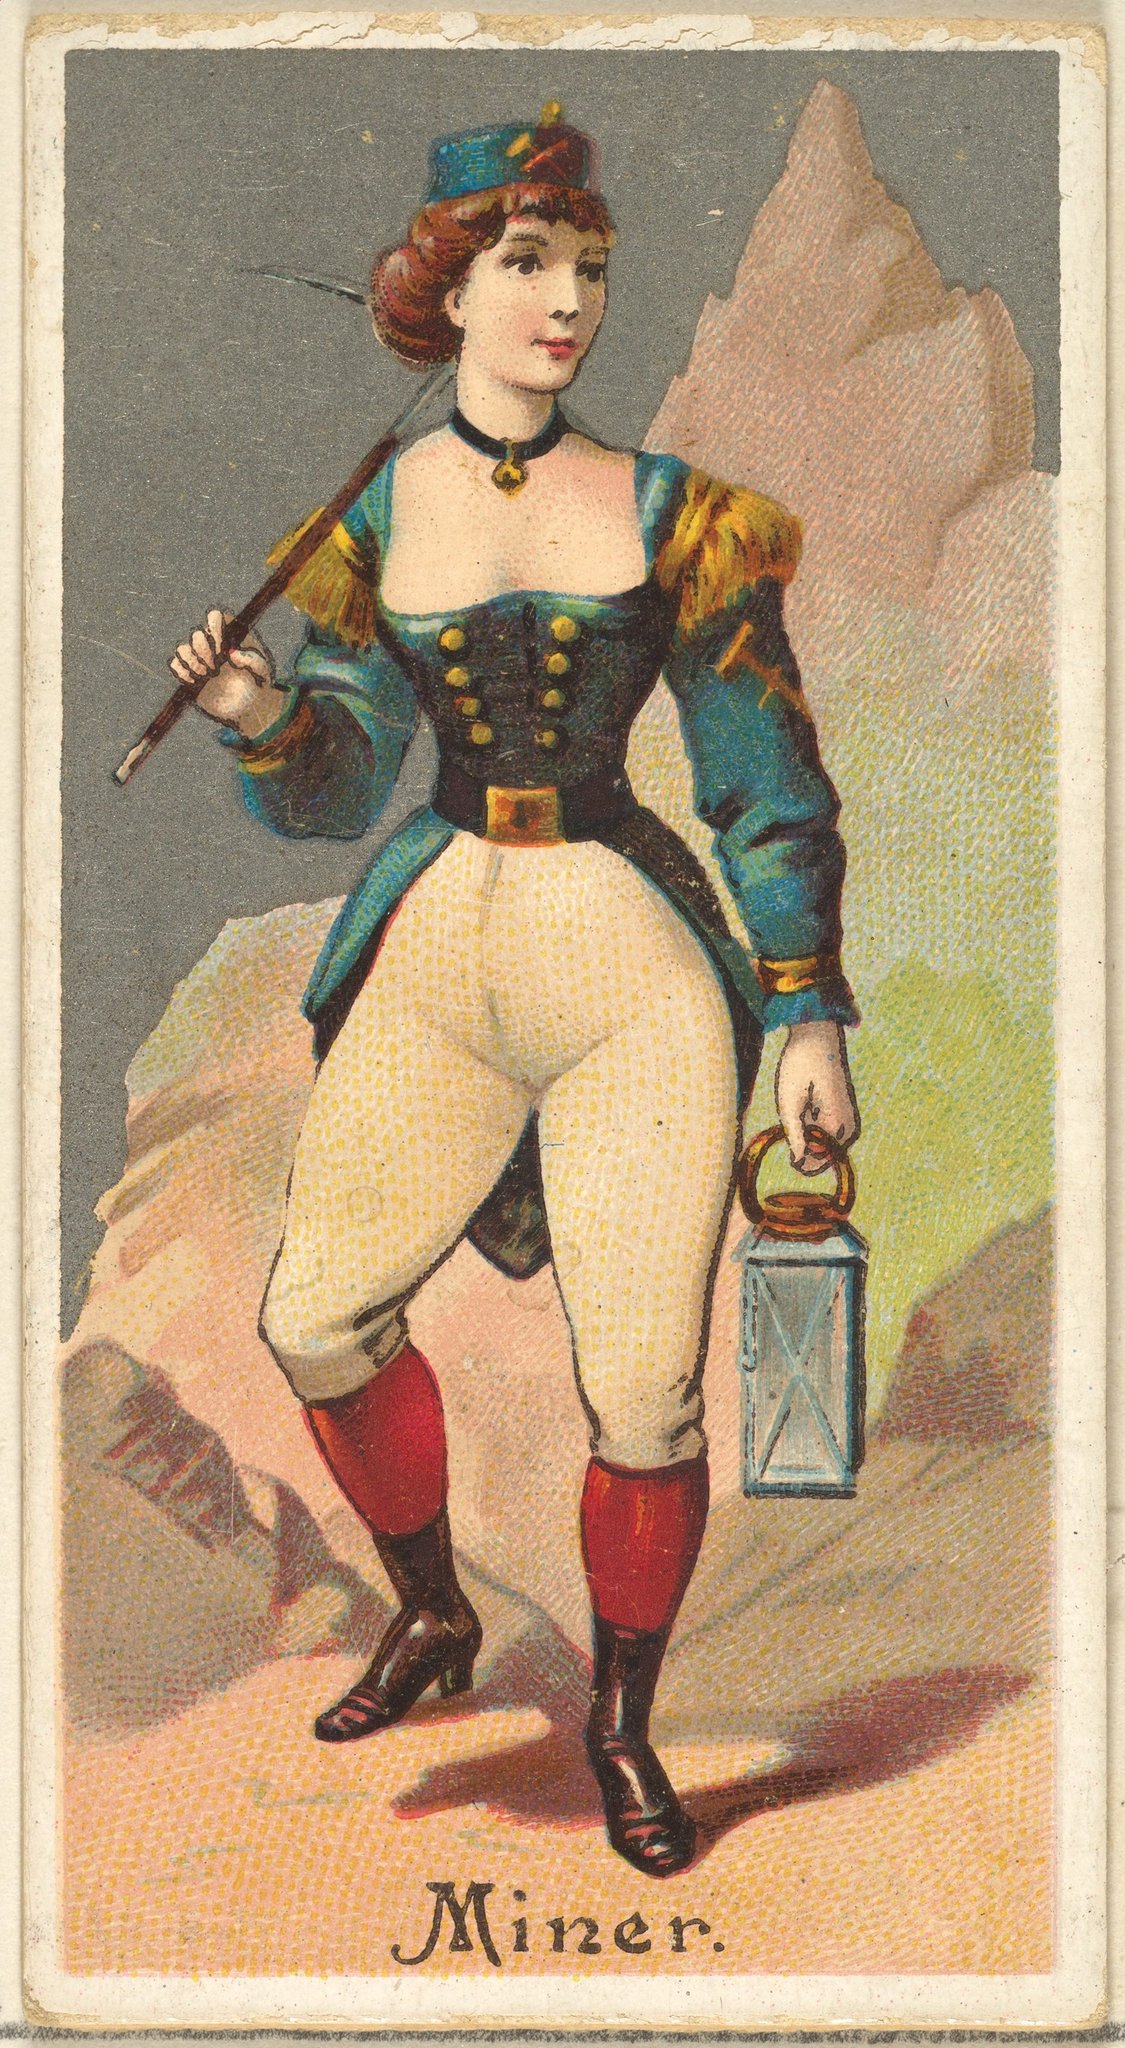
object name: print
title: Miner, from the Occupations for Women series (N166) for Old Judge and Dogs Head Cigarettes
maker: goodwin & company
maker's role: publisher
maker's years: 1850-1950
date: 1887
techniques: color lithograph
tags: women